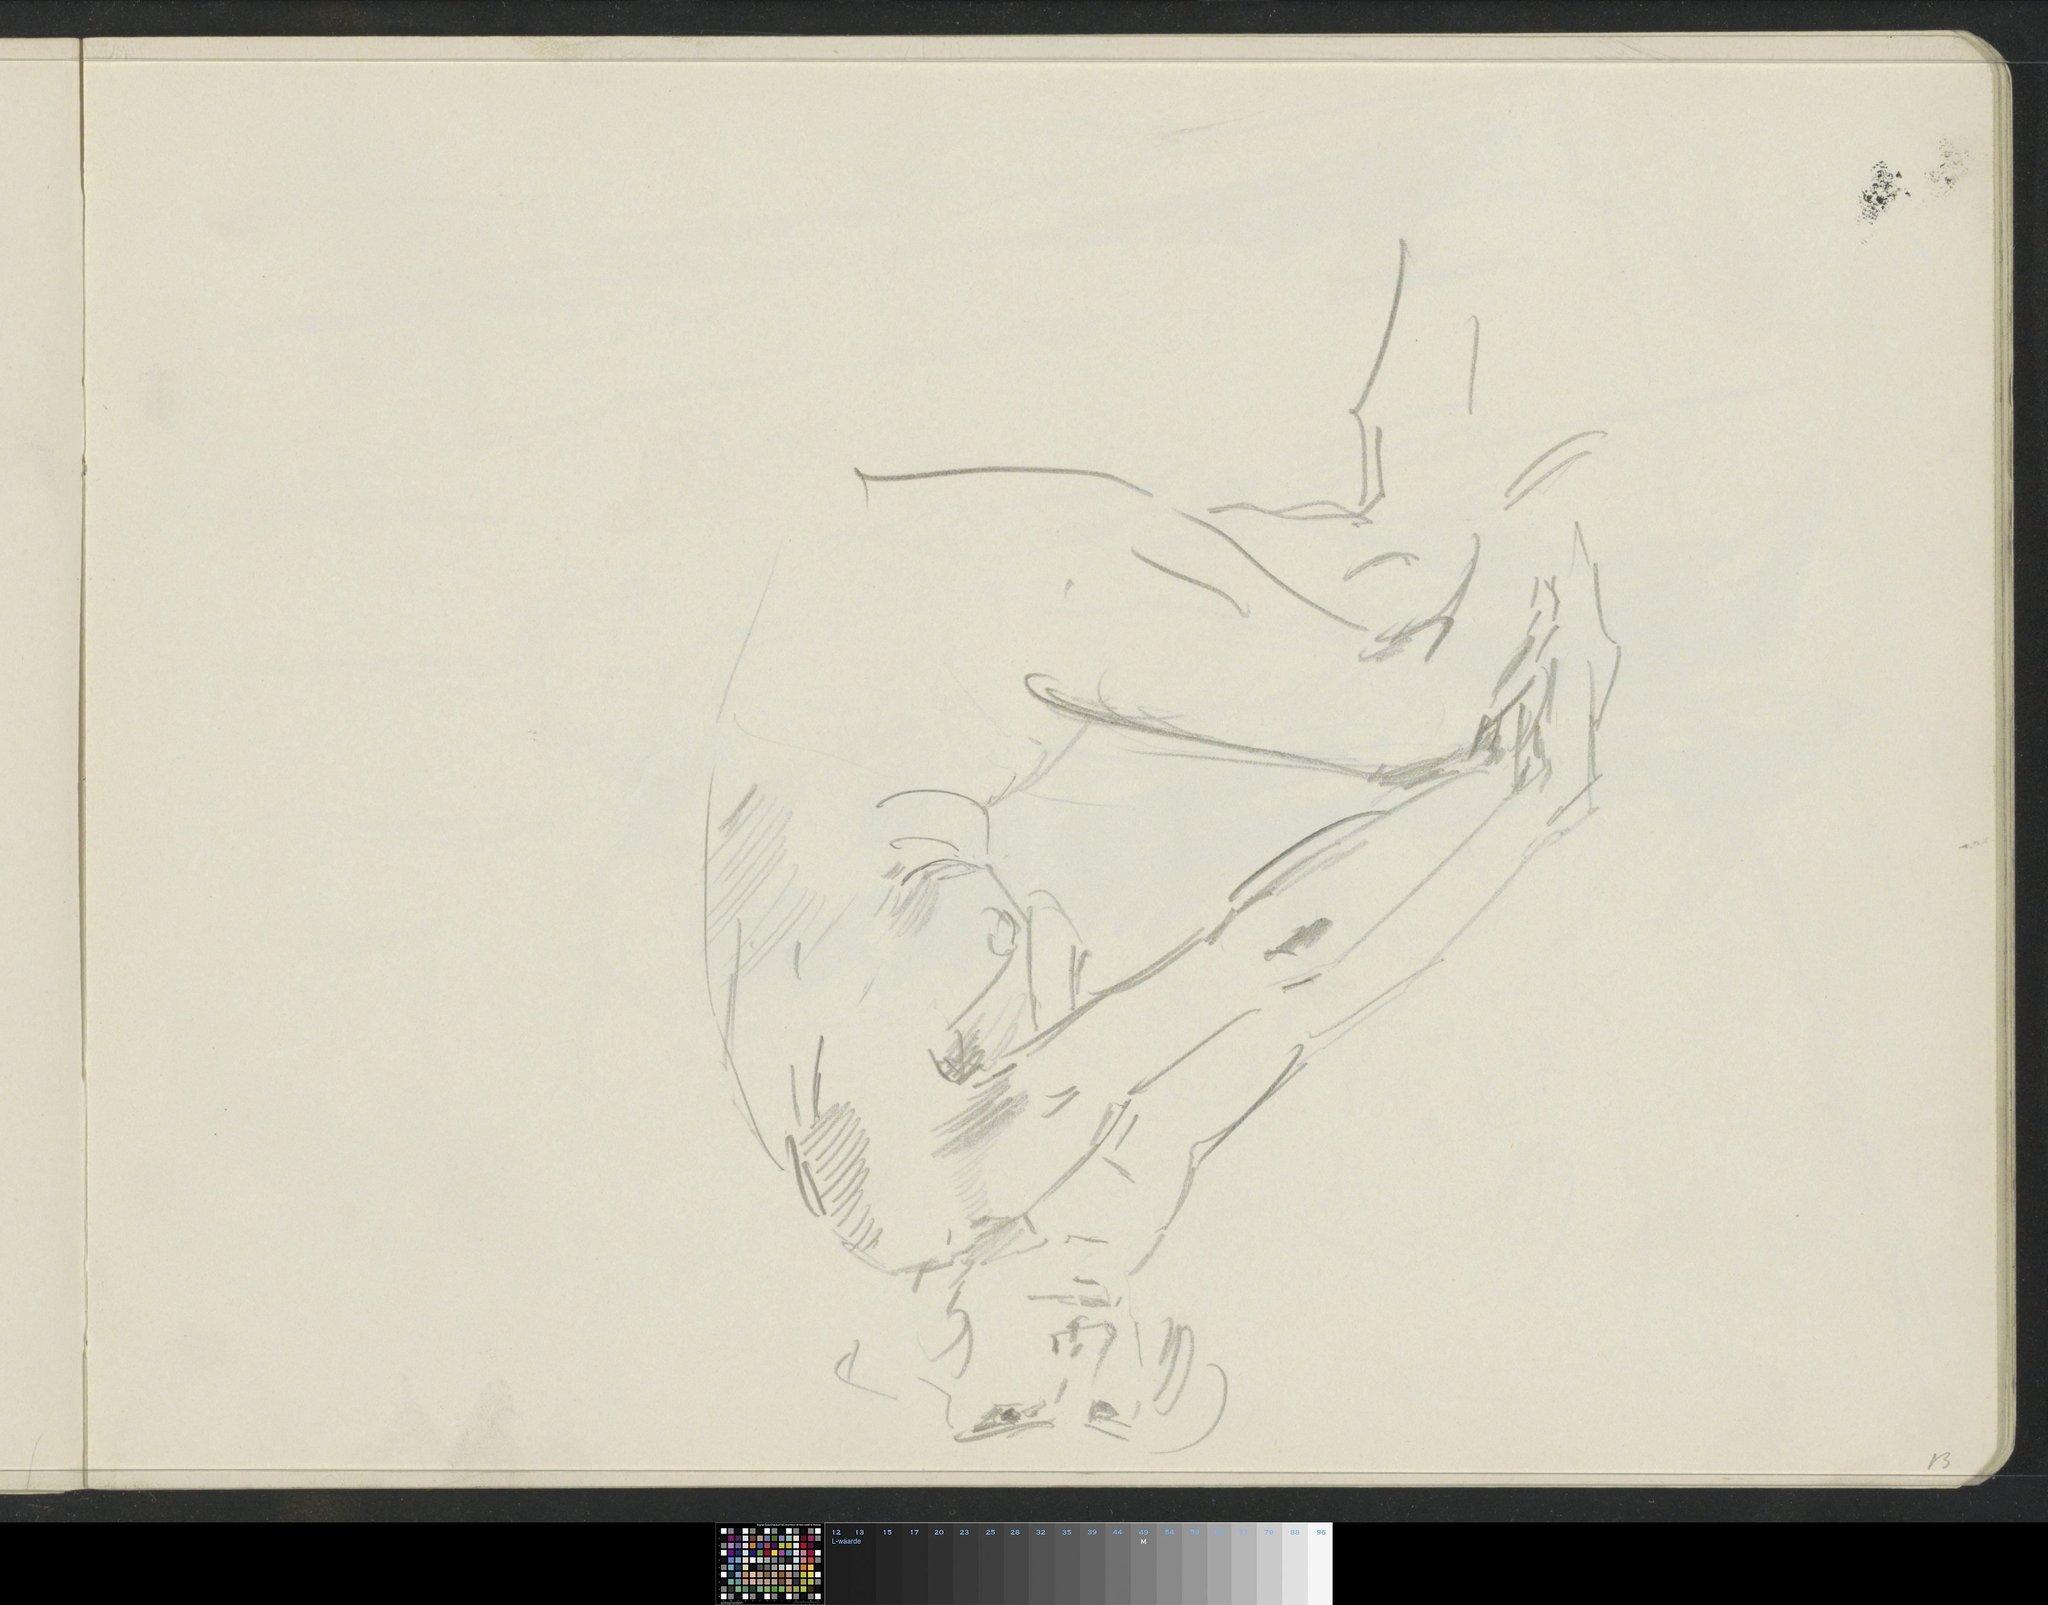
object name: sketchbook leaf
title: Seated Female Nude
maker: isaac israels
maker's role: draughtsman, painter, print maker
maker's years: 1865-1934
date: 1915-1934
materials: paper, pencil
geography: the hague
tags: the (nude) human figure; 'corpo humano' (ripa) - aa - female human figure (+ sitting)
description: Haar handen rusten op haar knieën. Blad 13 recto uit schetsboek XVII met 31 bladen.